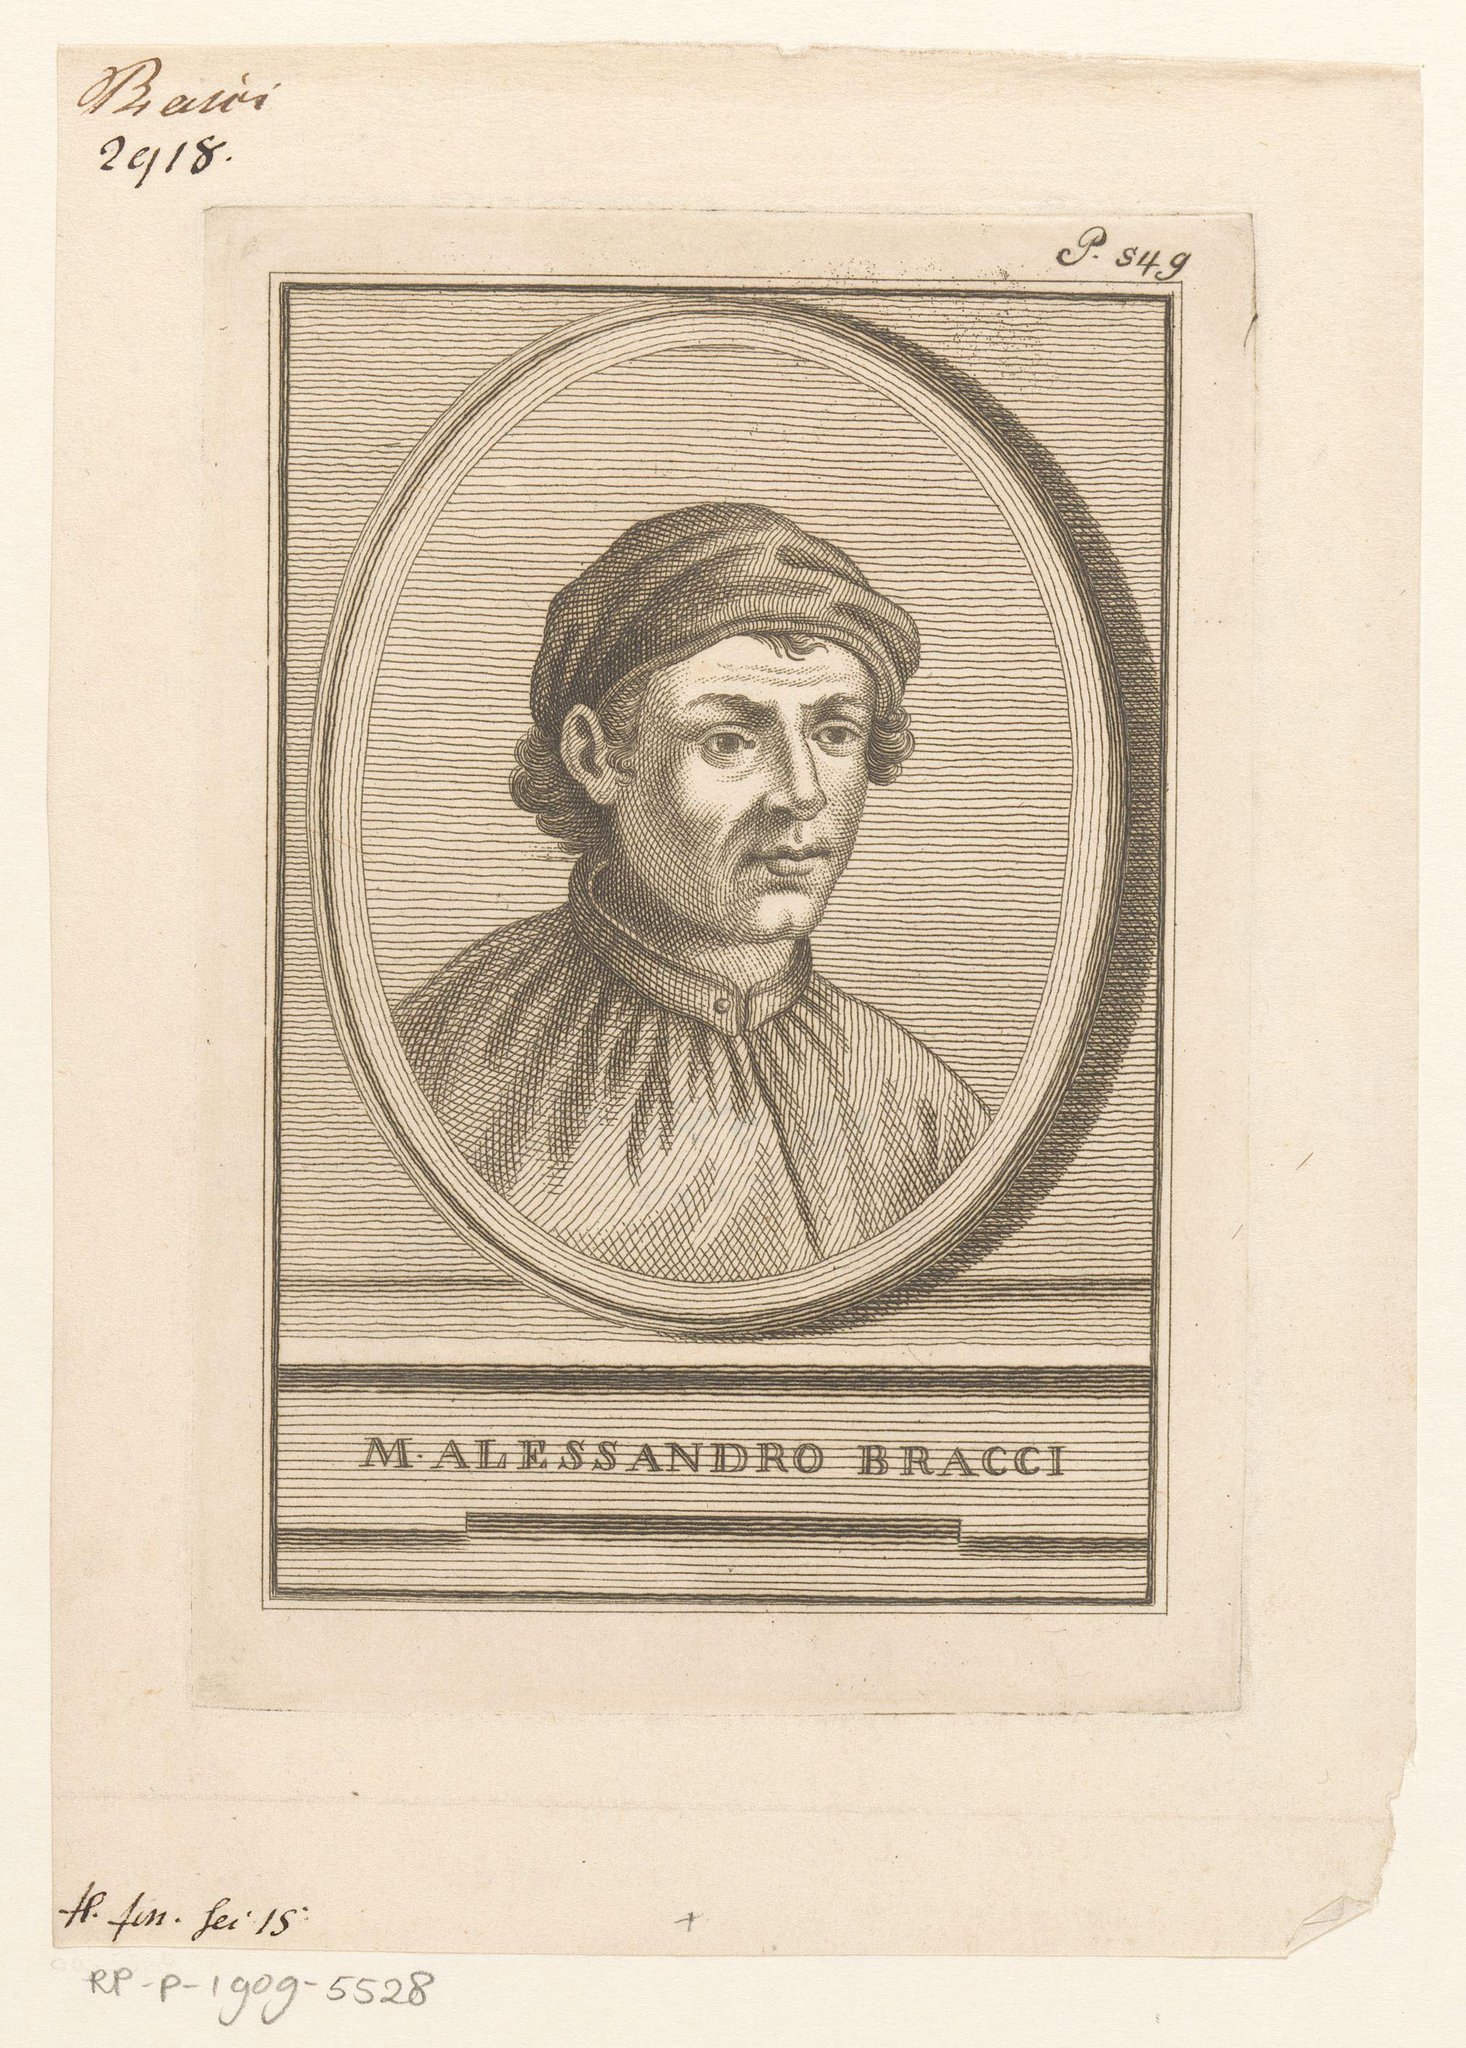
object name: book illustration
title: Portretten van schrijvers die liederen schreven voor Lorenzo de'Medici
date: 1750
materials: paper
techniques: engraving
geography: italy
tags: historical persons, portrait of a writer, writer, poet, author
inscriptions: collector's mark: Lugt 2228, inscription: ‘Bracci / 2918’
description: Prent gebruikt voor Grazzini, Anton Francesco. Tutti i trionfi, carri, mascherate o canti carnascialeschi andati per Firenze dal tempo del Magnifico Lorenzo de' Medici fino all' anno 1559 : in questa seconda edizione corretti, con diversi MSS. collazionati, delle loro varie lezioni arricchiti, notabilmente accresciuti, e co' ritratti di ciascun poeta adornate. Lucca: Cosmopoli, 1750.